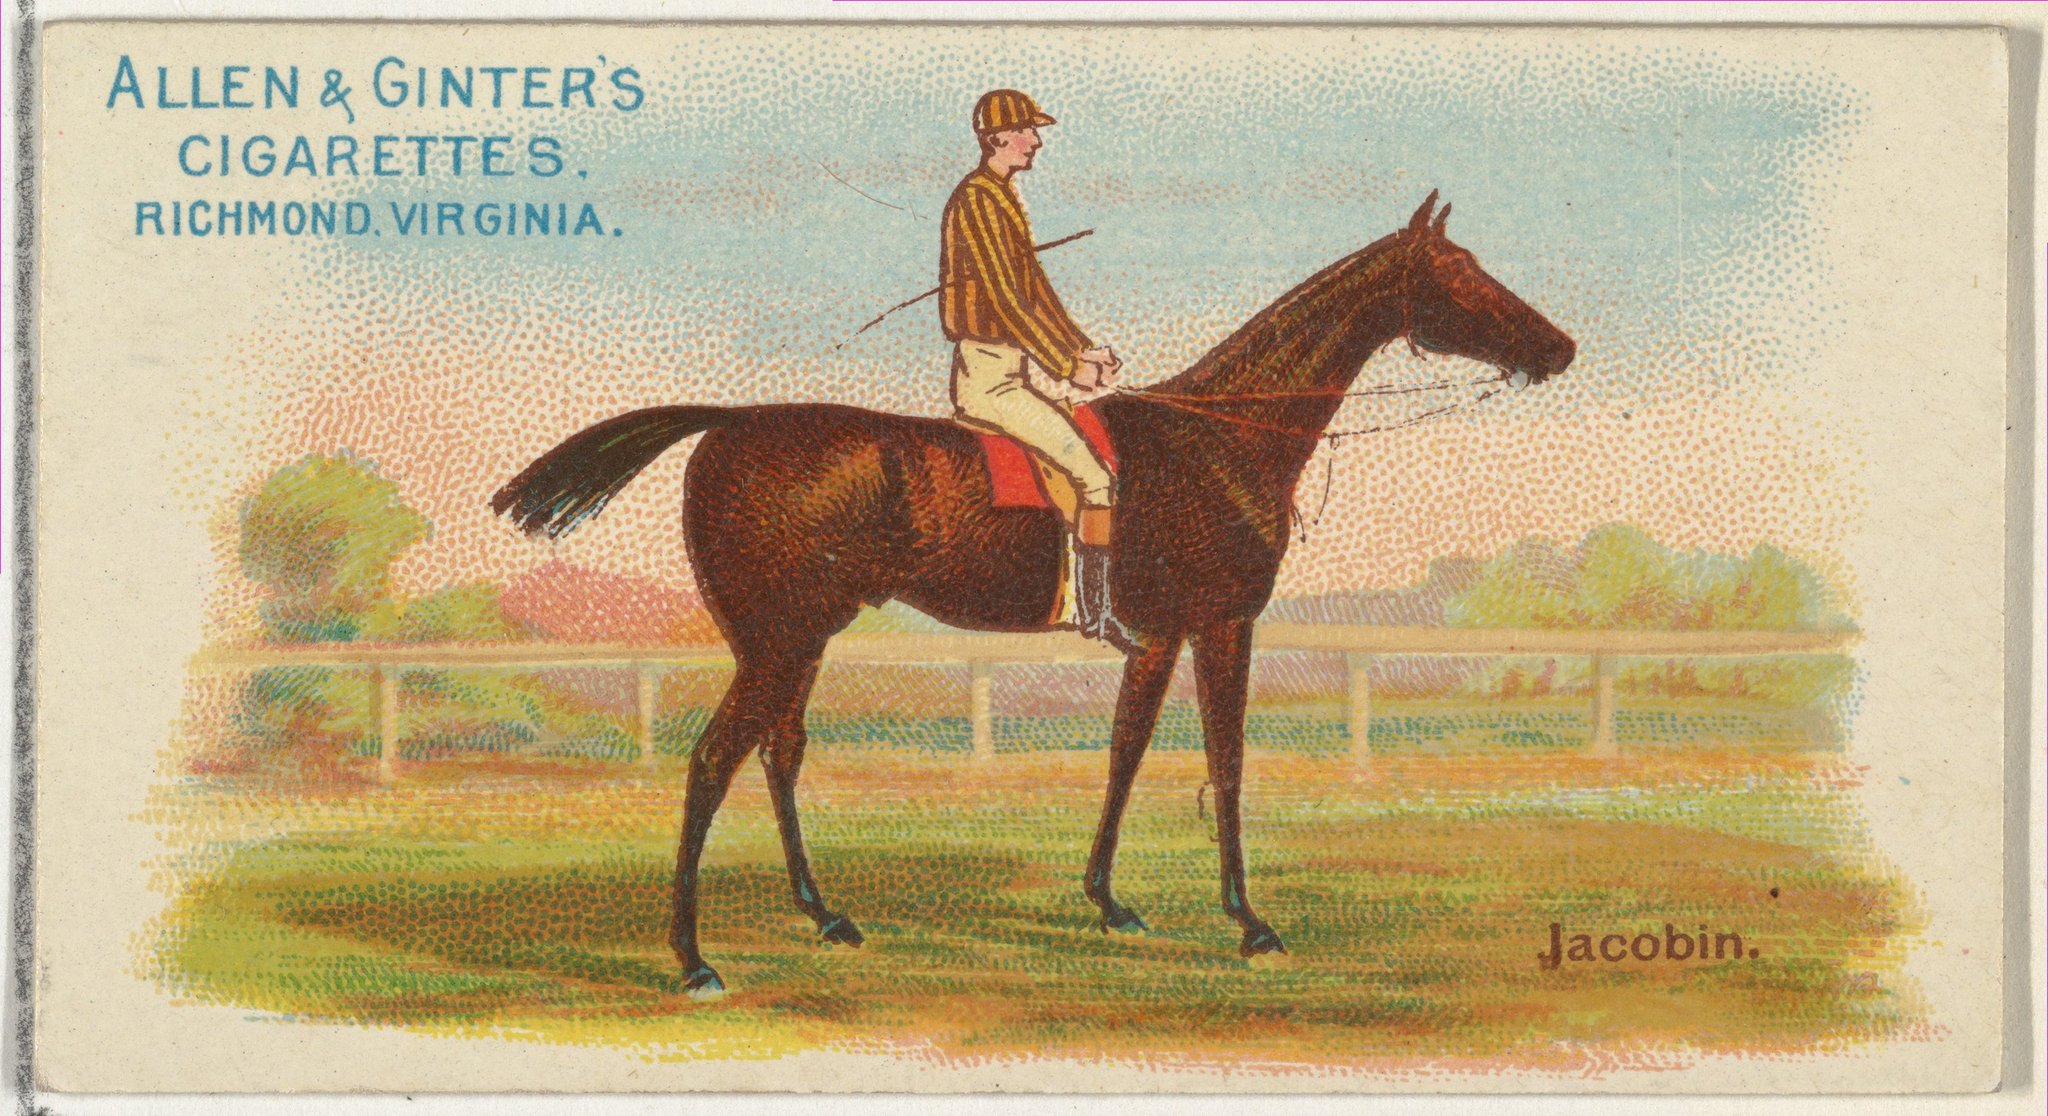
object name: print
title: Jacobin, from The World's Racers series (N32) for Allen & Ginter Cigarettes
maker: allen & ginter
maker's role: publisher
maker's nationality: american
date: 1888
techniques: color lithograph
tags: men,horses,jockeys